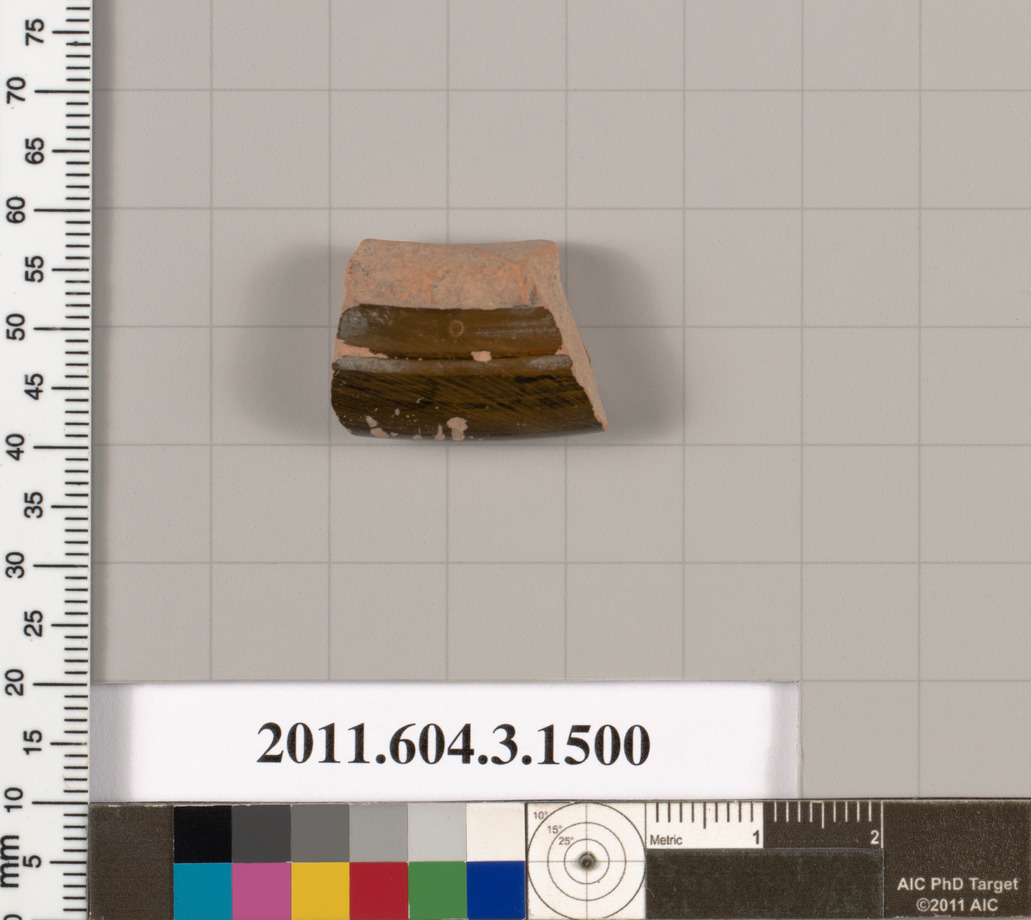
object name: skyphos fragment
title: Terracotta fragment of a skyphos (deep drinking cup)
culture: greek, attic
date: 600-401 BCE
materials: terracotta